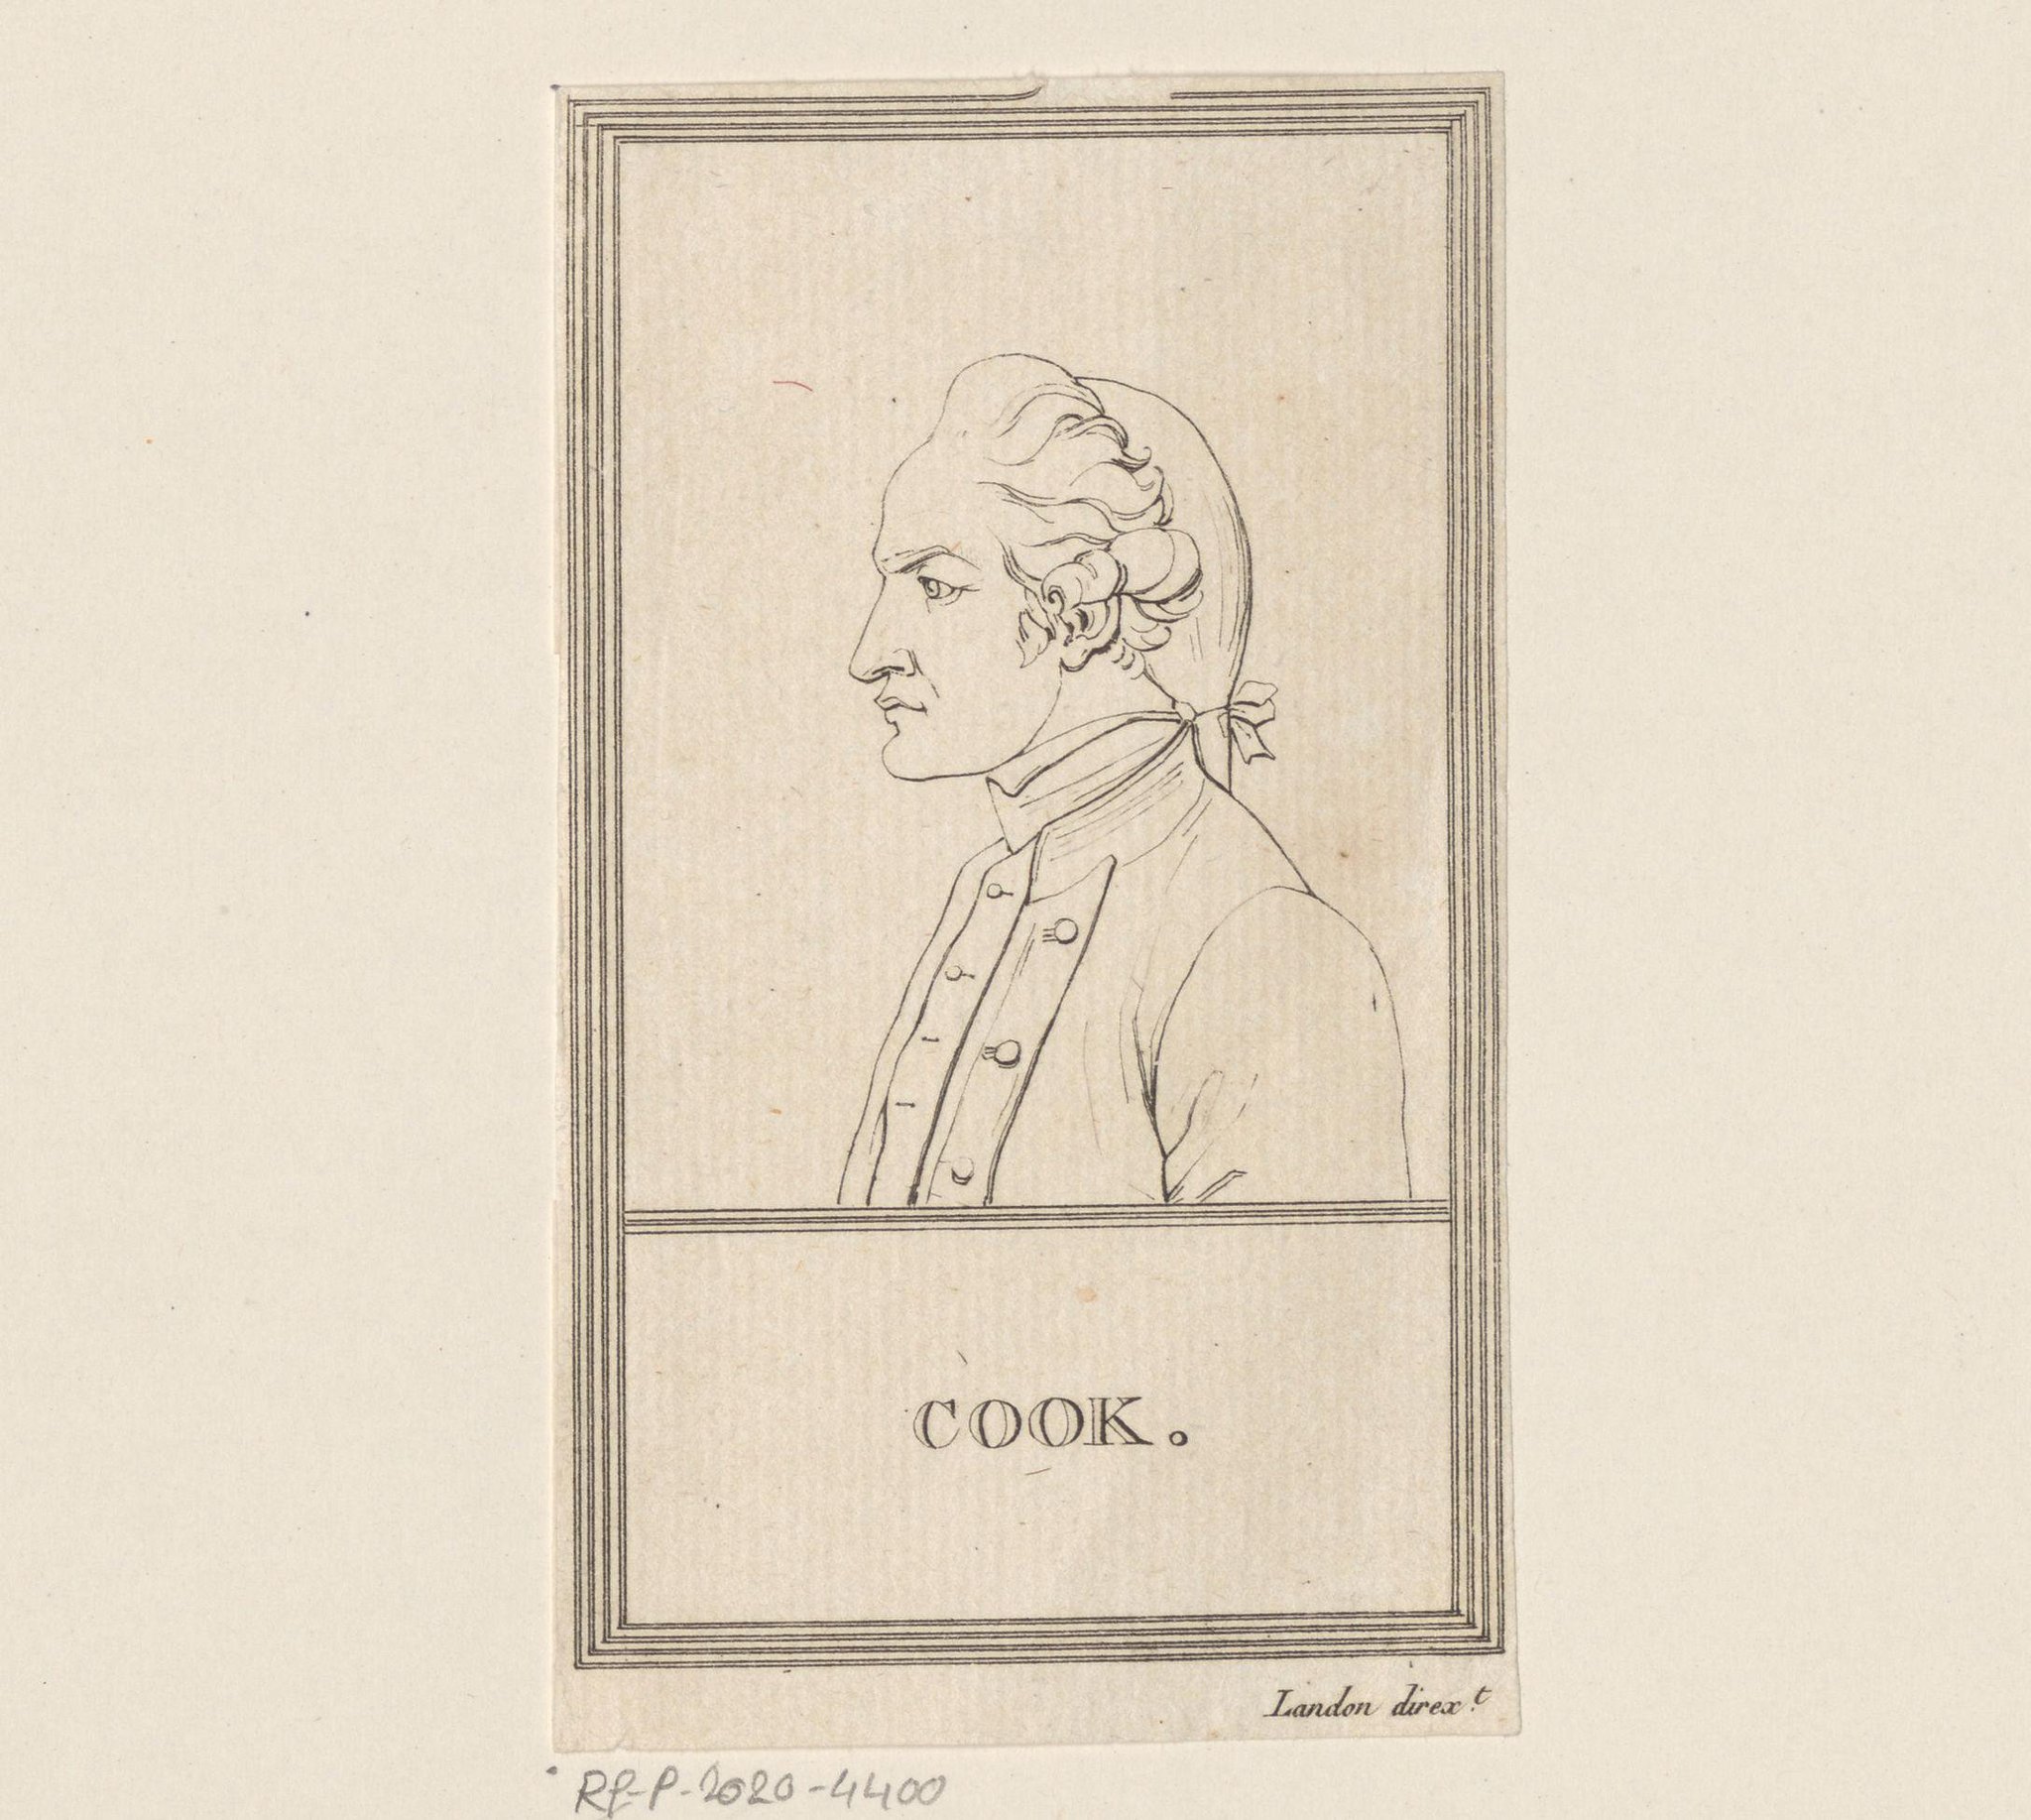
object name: print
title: Portret van James Cook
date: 1805-1811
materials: paper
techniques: etching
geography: paris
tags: james cook, historical persons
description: Prent waarschijnlijk uit: Galerie historique des hommes les plus célèbres (...). Parijs: Charles Paul Landon, 1805-1811.